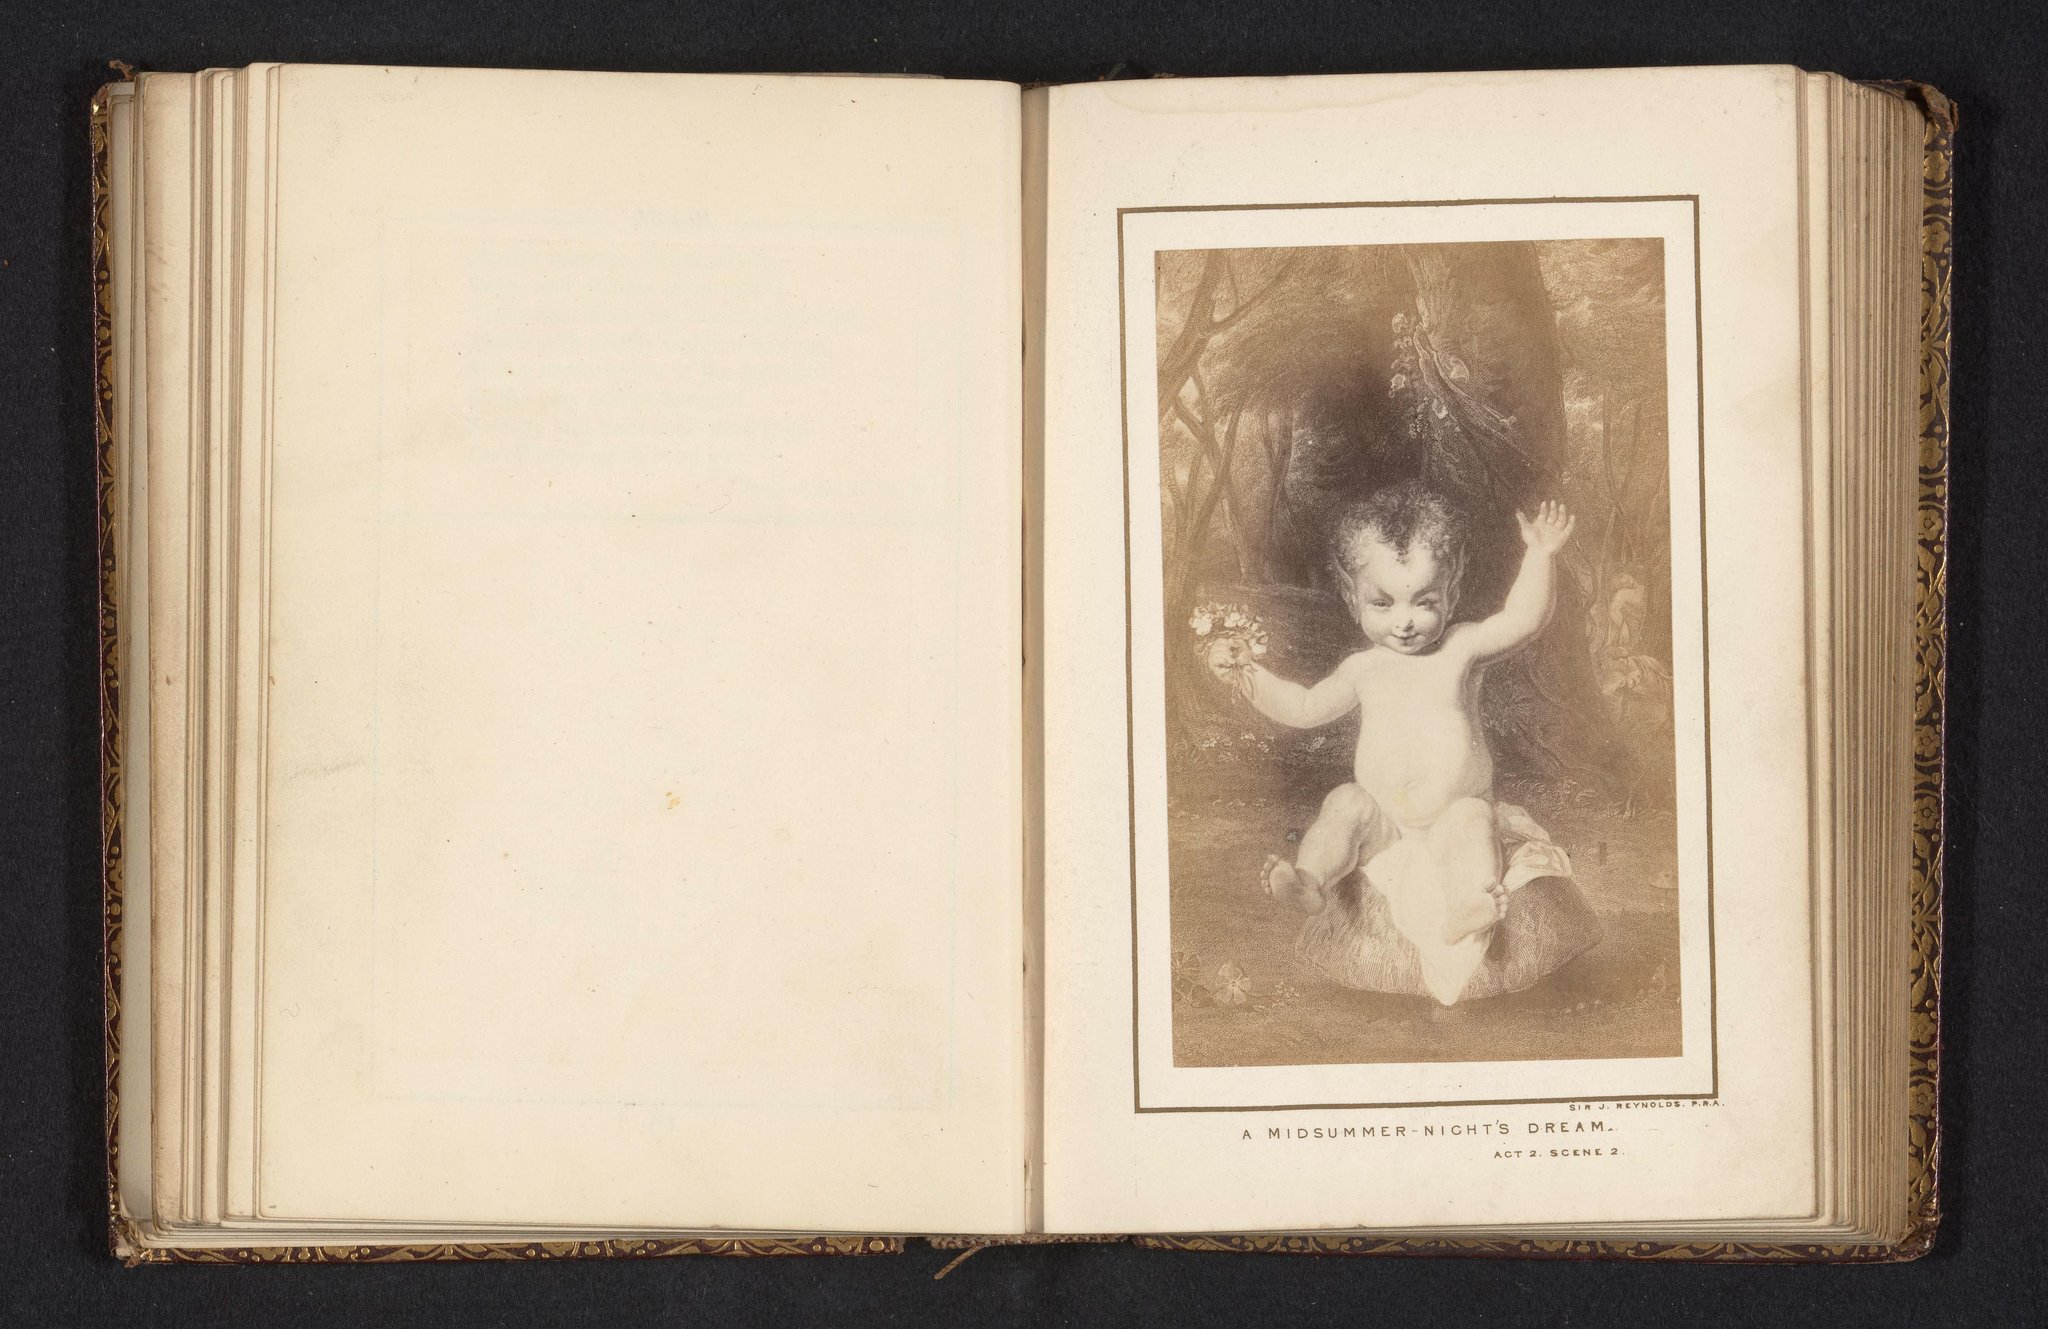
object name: reproduction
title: A Midsummernight's Dream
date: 1866-1876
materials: photographic support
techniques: albumen print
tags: 83(shakespeare, midsummernight's dream)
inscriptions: inscription: ‘Act 2. scene 2’